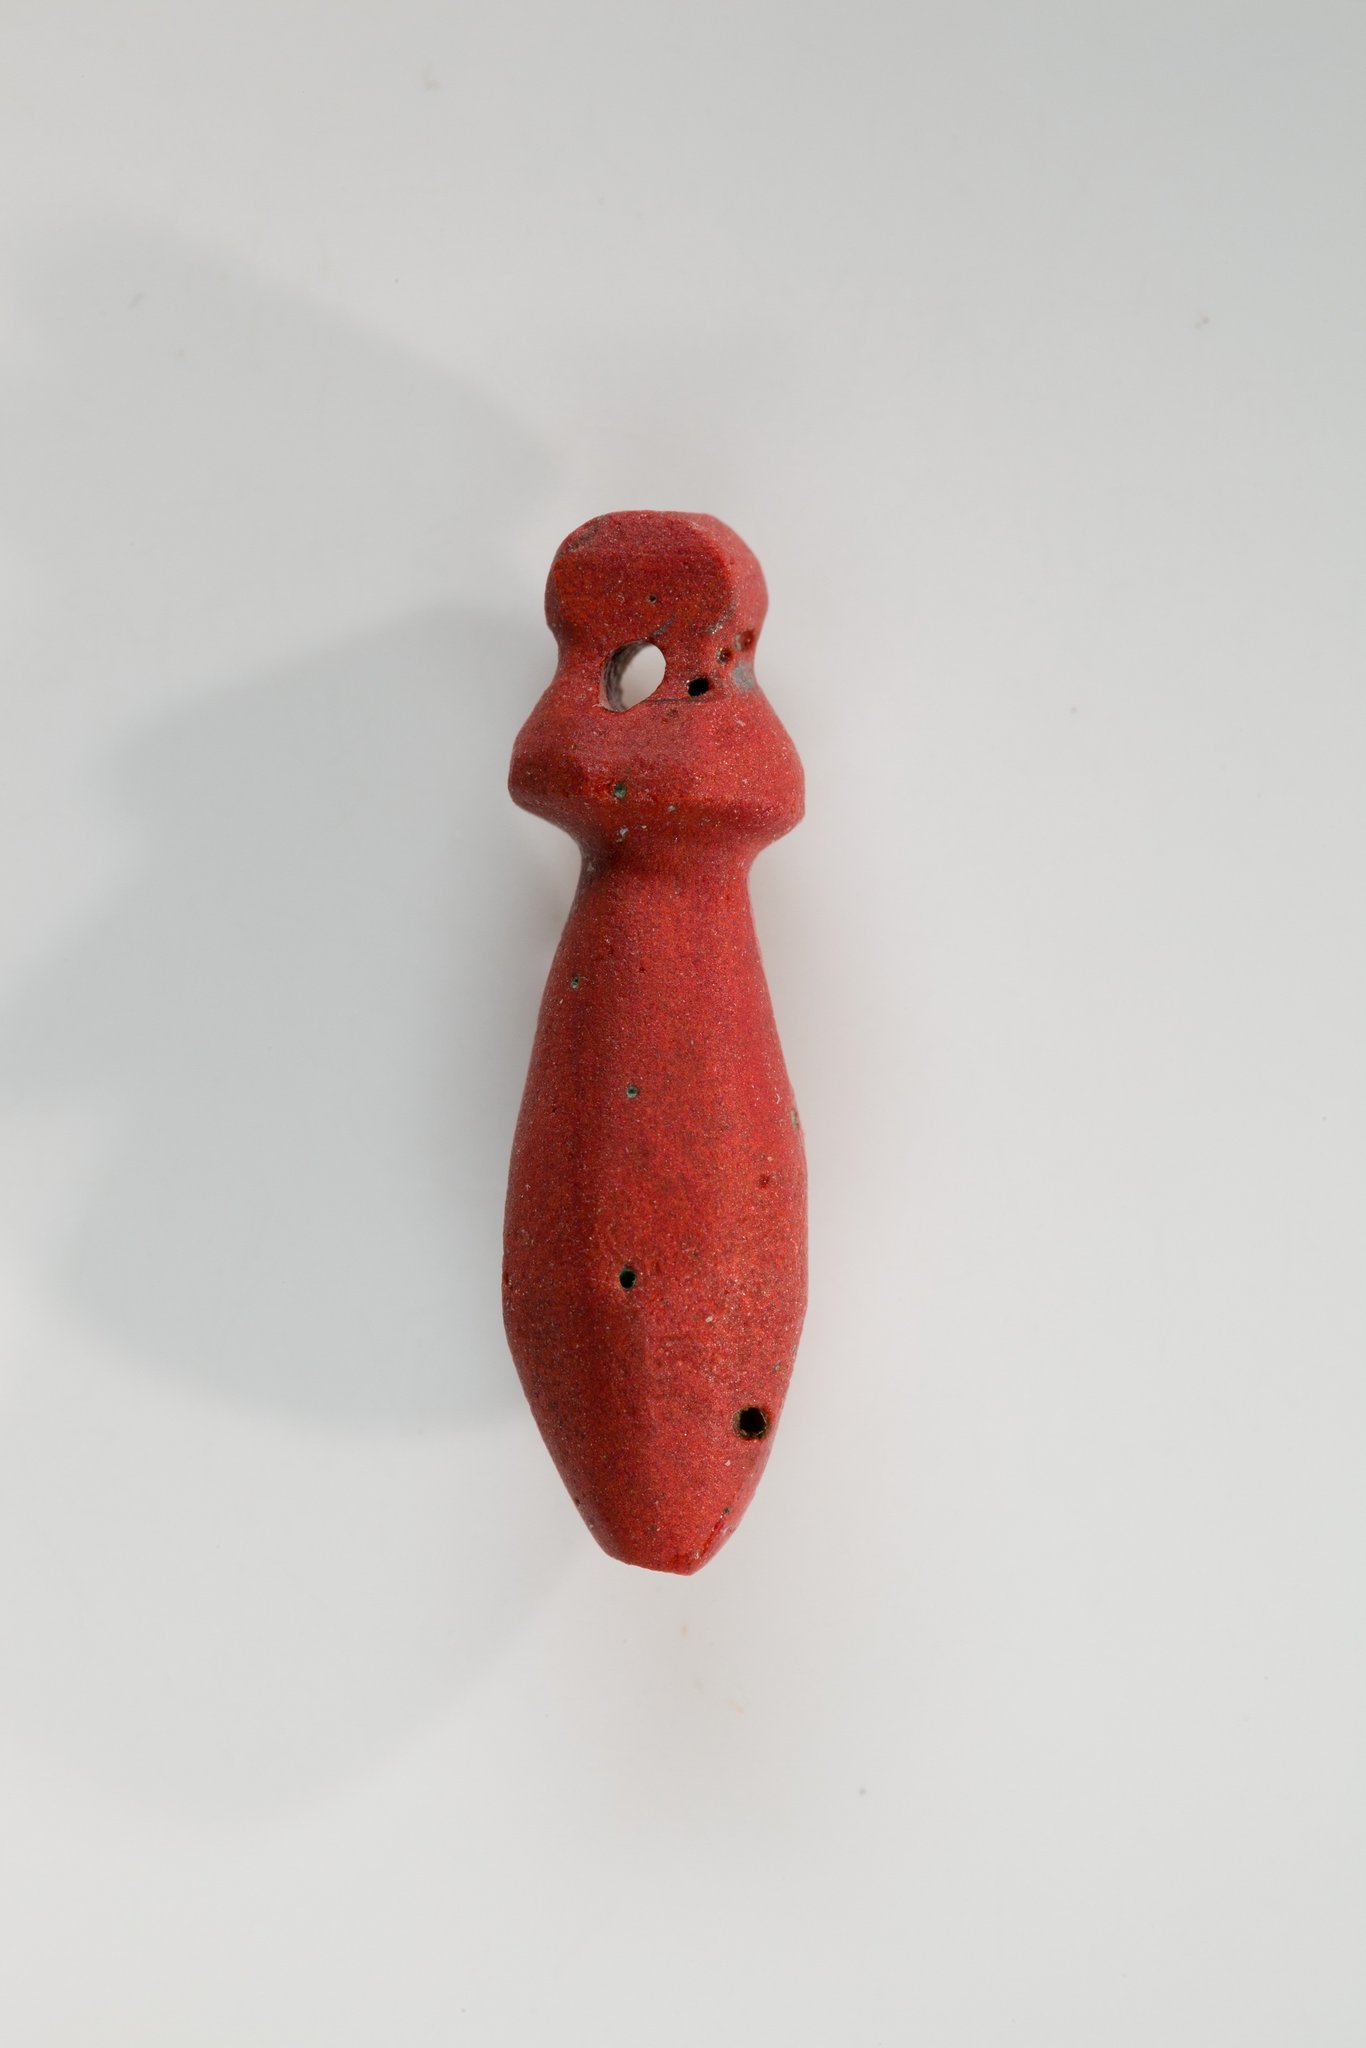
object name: amulet, papyrus scepter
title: Papyrus scepter (wadj) amulet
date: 1070-945 BCE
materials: glass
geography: egypt